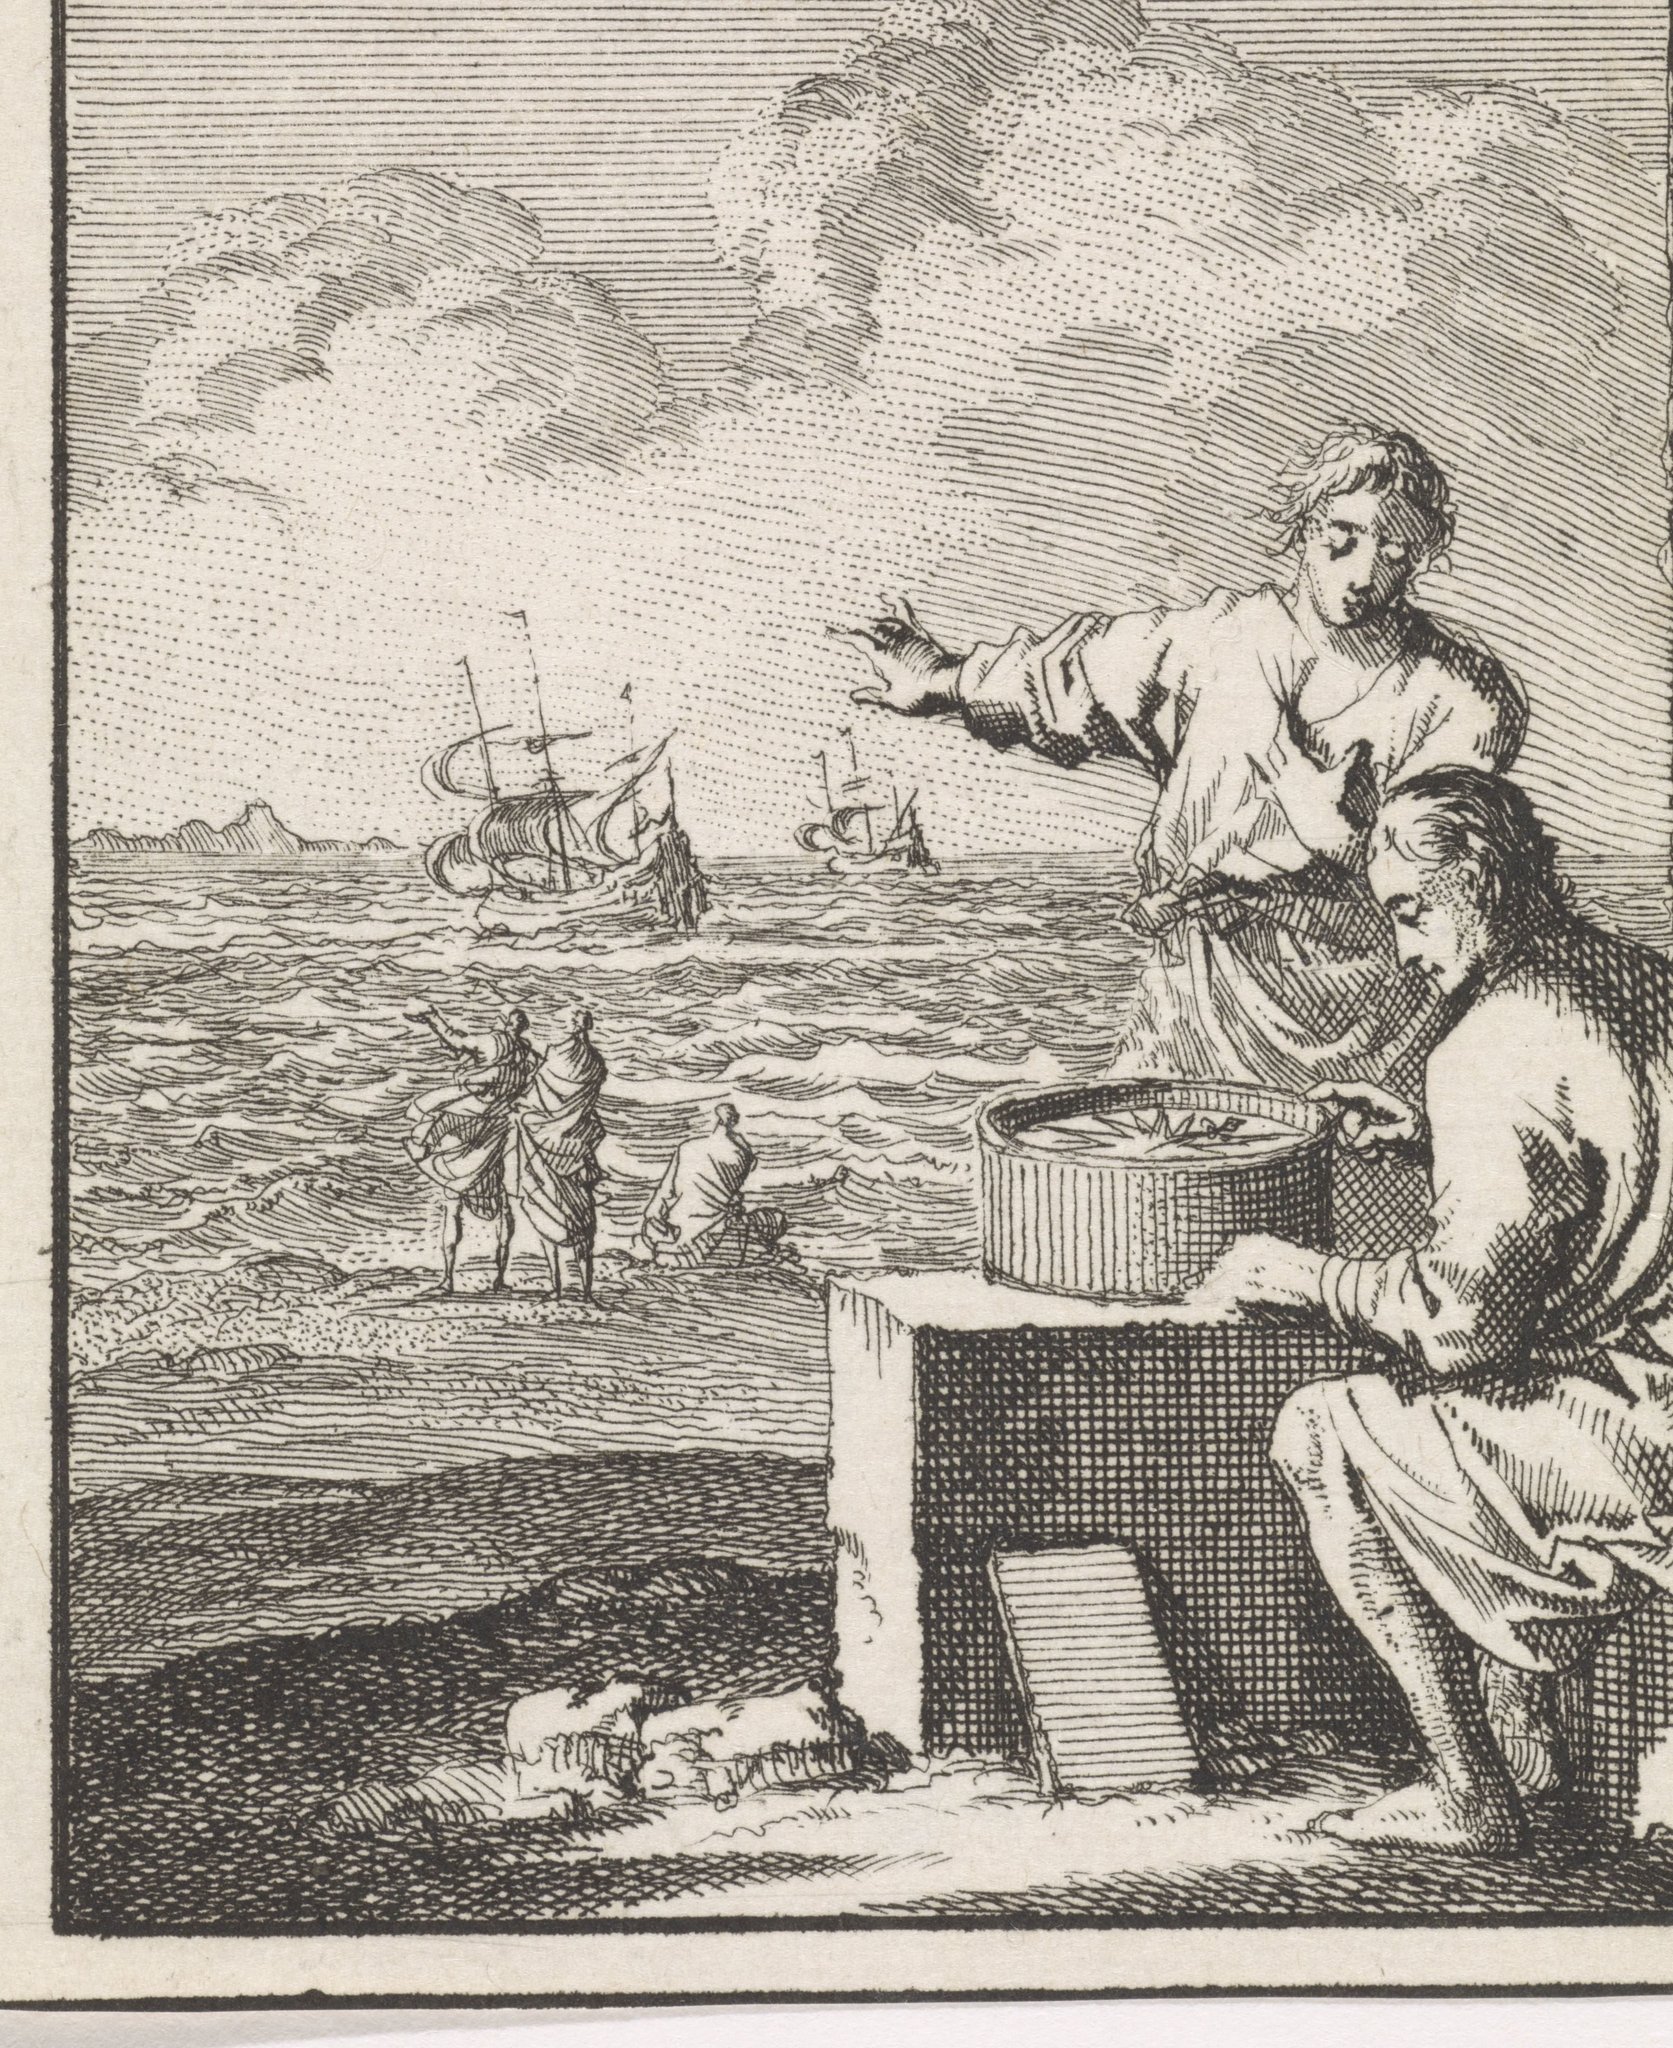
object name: book illustration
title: Twee mannen aan een strand beschouwen een kompas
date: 1700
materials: paper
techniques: etching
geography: amsterdam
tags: ships (in general), compass, coast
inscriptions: collector's mark: Lugt 2228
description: Boekillustratie voor Jan Huygen. Stichtelyke rymen op verscheiden stoffen. Amsterdam: Gedrukt door Jacobus van Herdenberg voor Jan Huygen, 1700, p. 112.